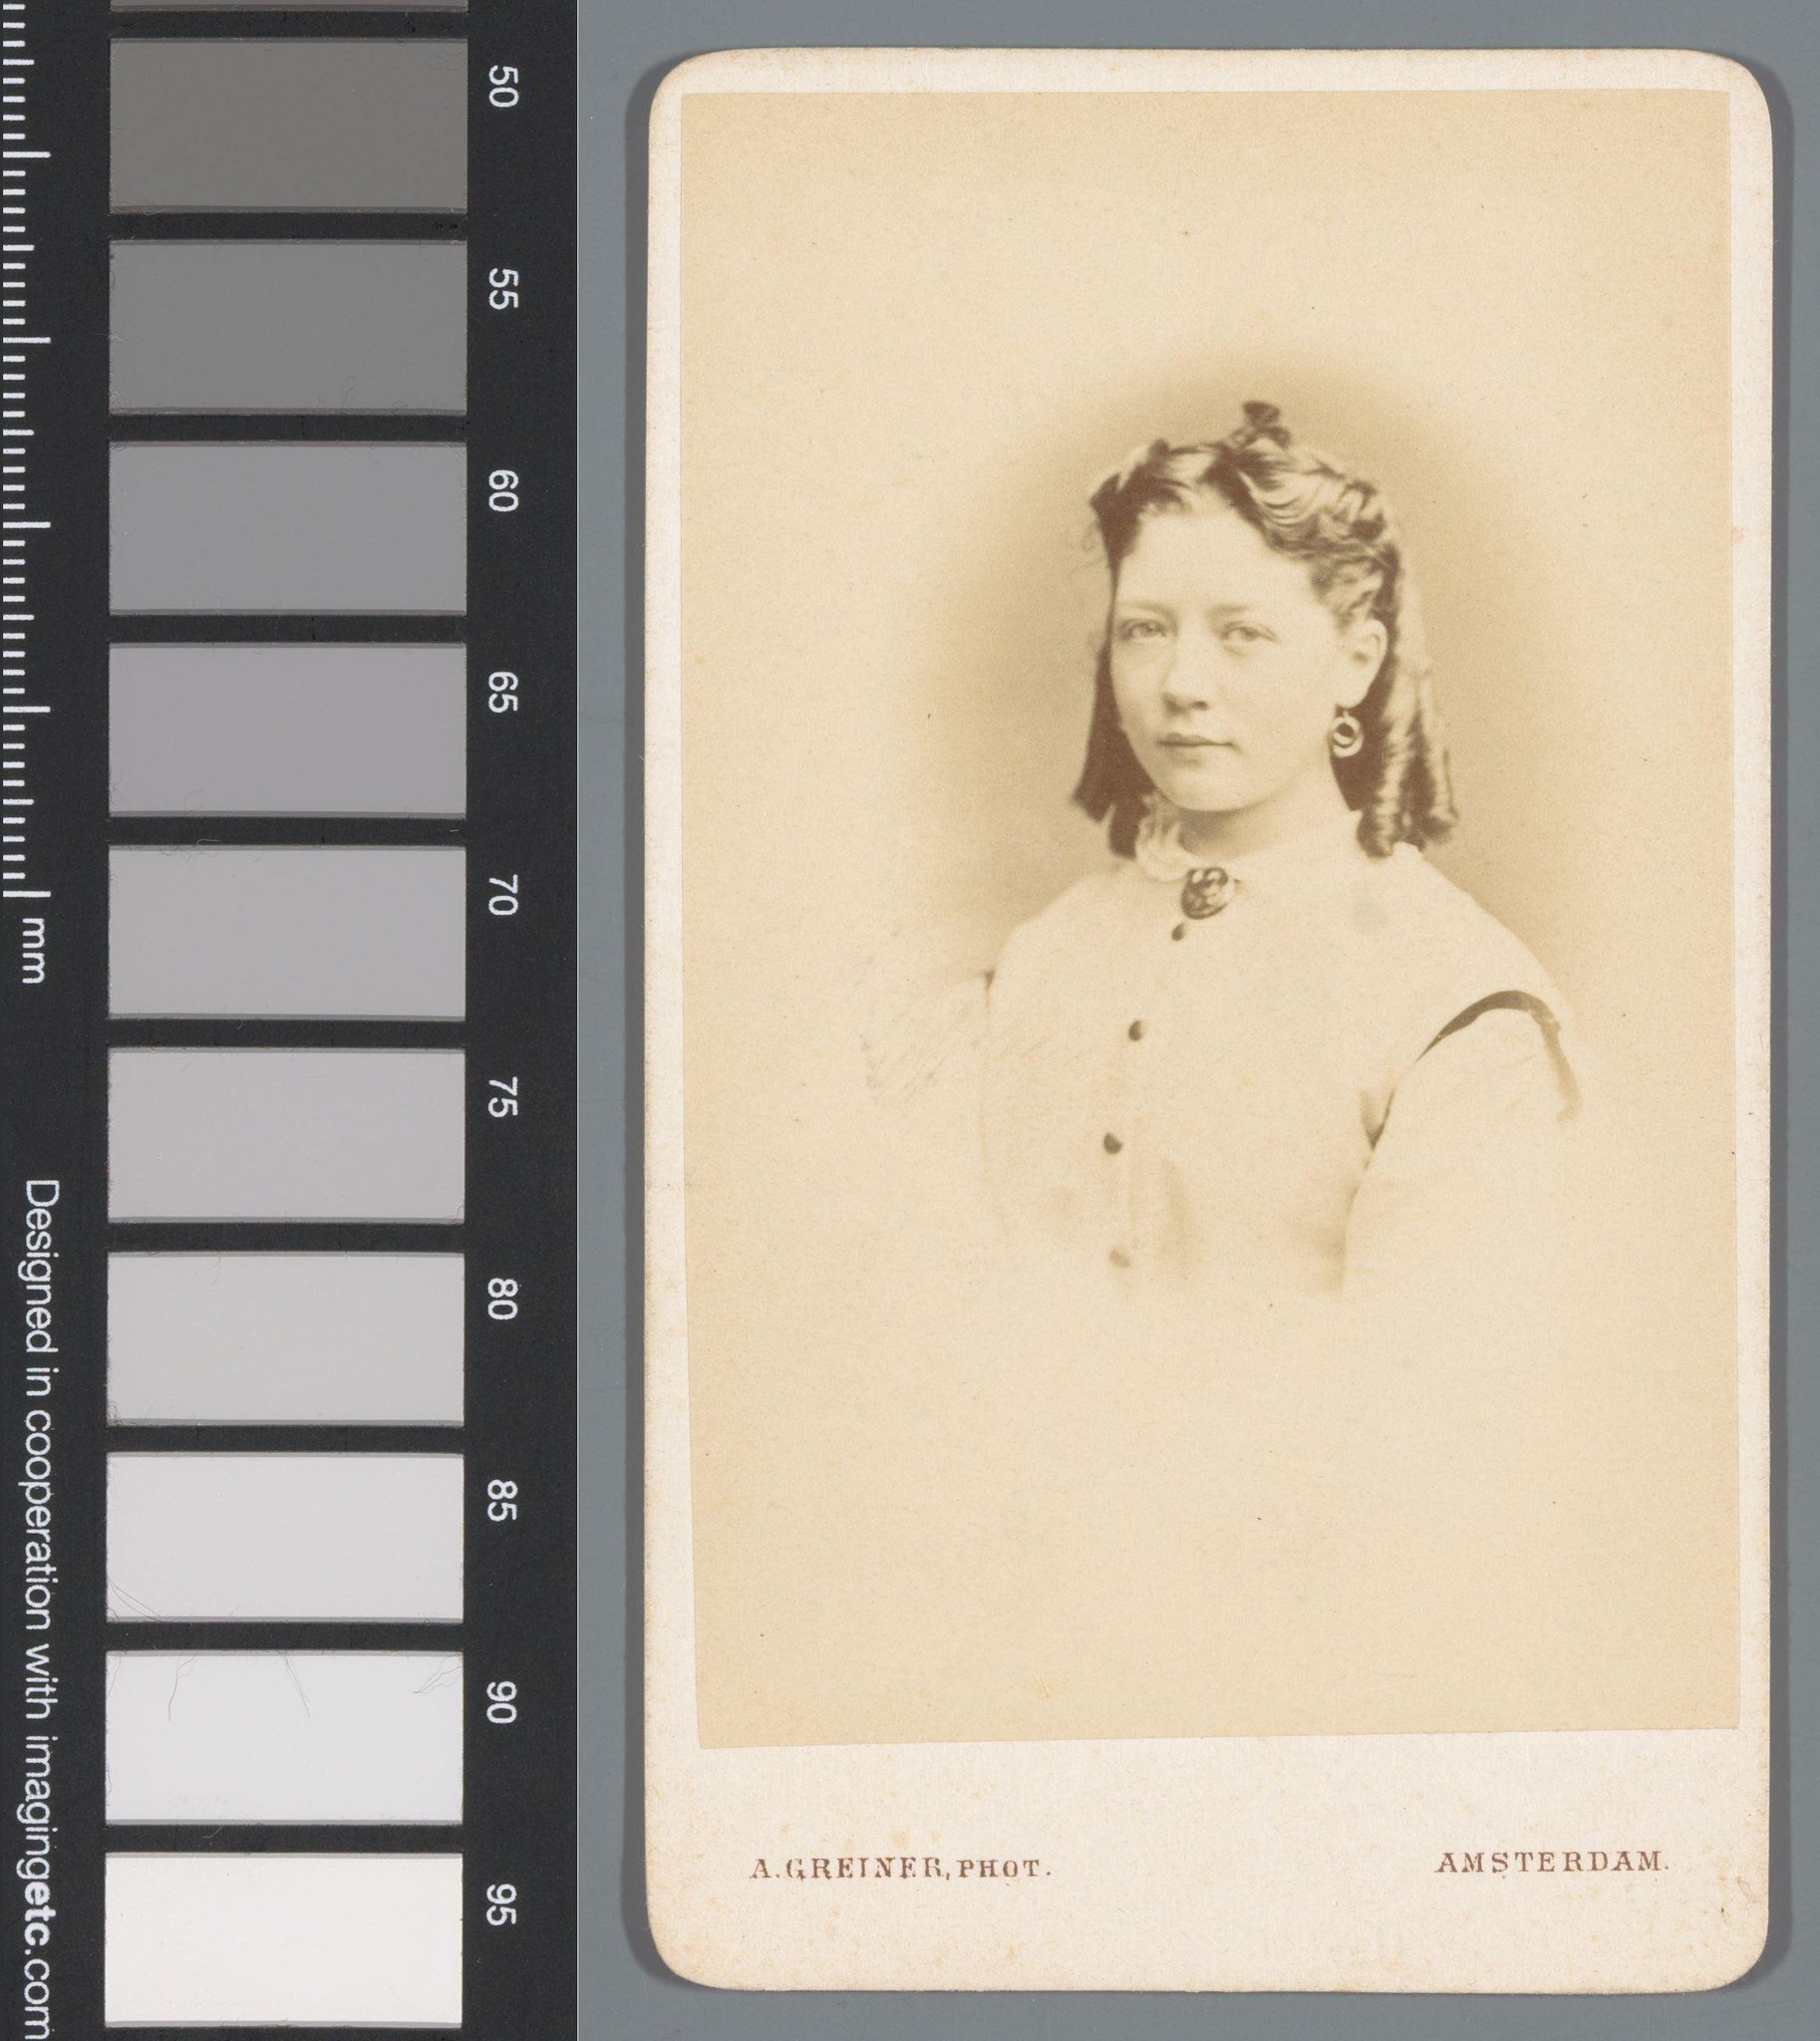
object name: photograph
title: Portret van een onbekende vrouw met pijpenkrullen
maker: albert greiner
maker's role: fotograaf, fotostudio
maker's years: 1833-1890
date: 1861-1874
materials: cardboard, paper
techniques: albumen print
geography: amsterdam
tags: historical persons - bb - woman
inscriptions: inscription: ‘AG/ A. GREINER/ Photograf/ NIEUWENDIJK L. 87/ AMSTERDAM’